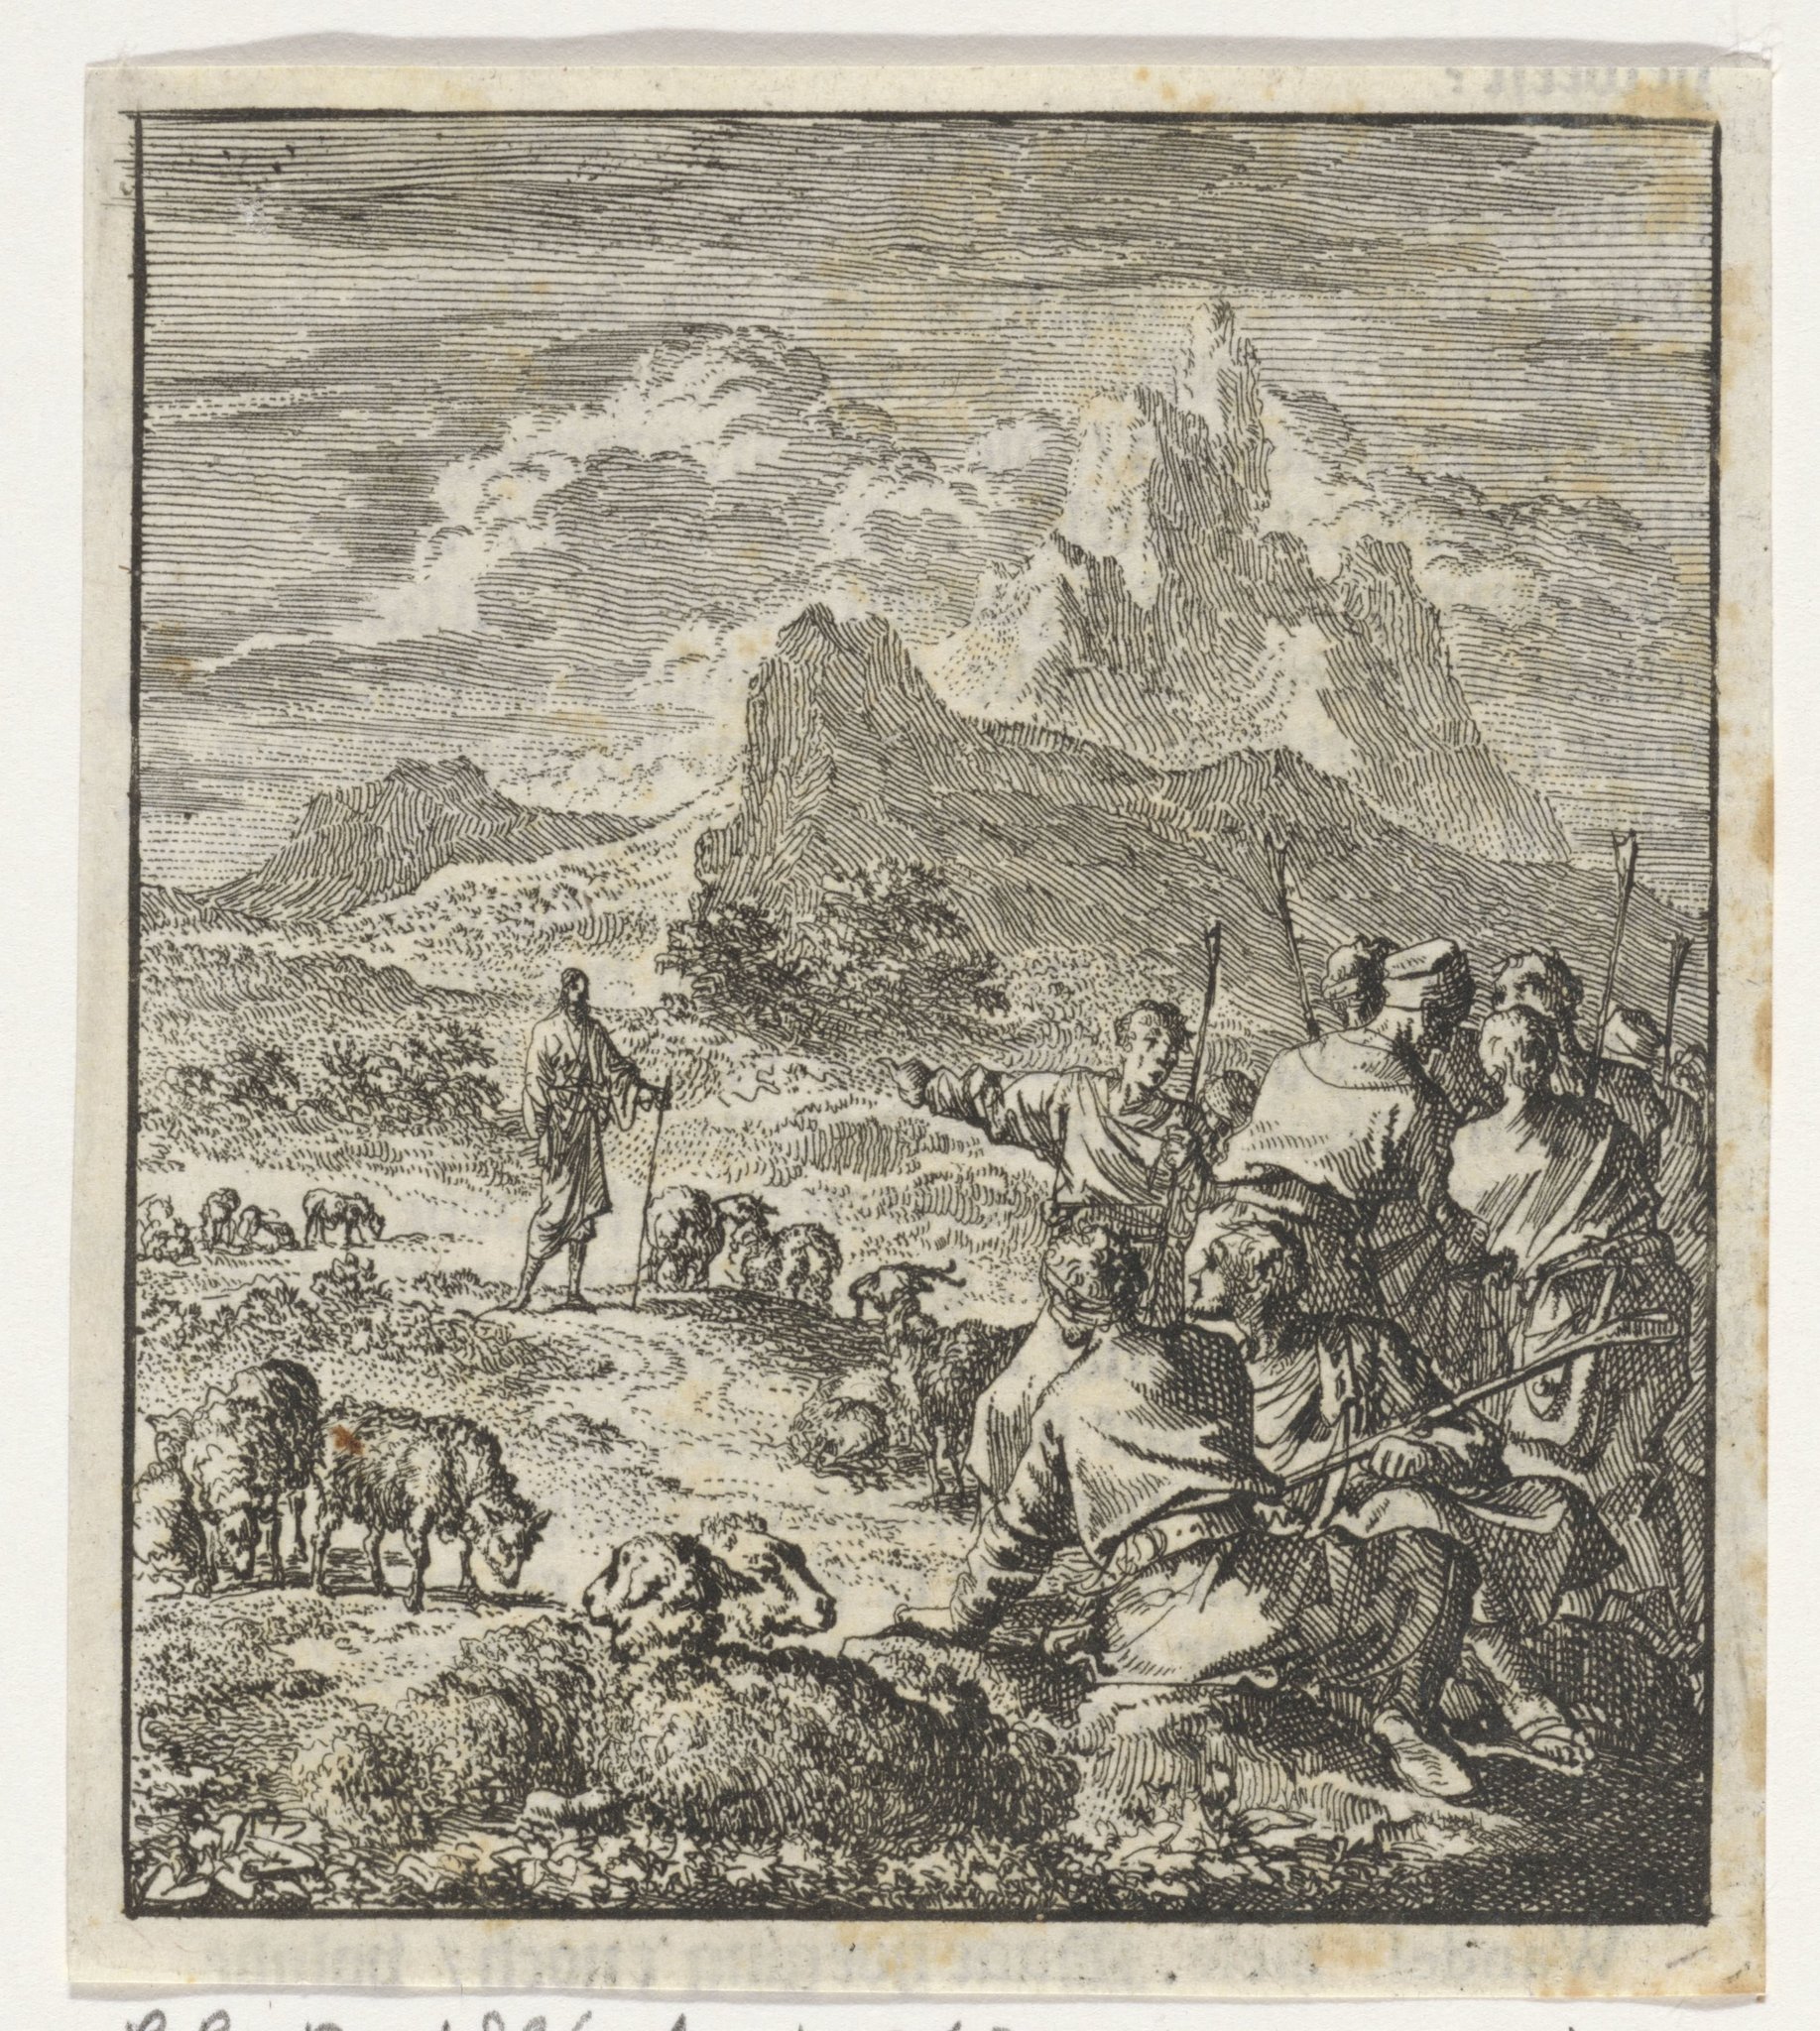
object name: book illustration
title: Zonen van Jakob met hun kudde wijzen naar de naderende Jozef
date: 1706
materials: paper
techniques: etching, letterpress printing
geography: amsterdam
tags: jacob works as a herdsman for seven years in exchange for rachel, herding, herdsman, herdswoman, shepherd, shepherdess, cowherd, etc.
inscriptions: collector's mark: Lugt 2228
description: Illustratie voor: Schabaalje, Jean Philipsz. De vermeerderde lust-hof des gemoeds. Amsterdam: Jan Rieuwertsz. (II) en Barent Visscher, 1706, p. 168.